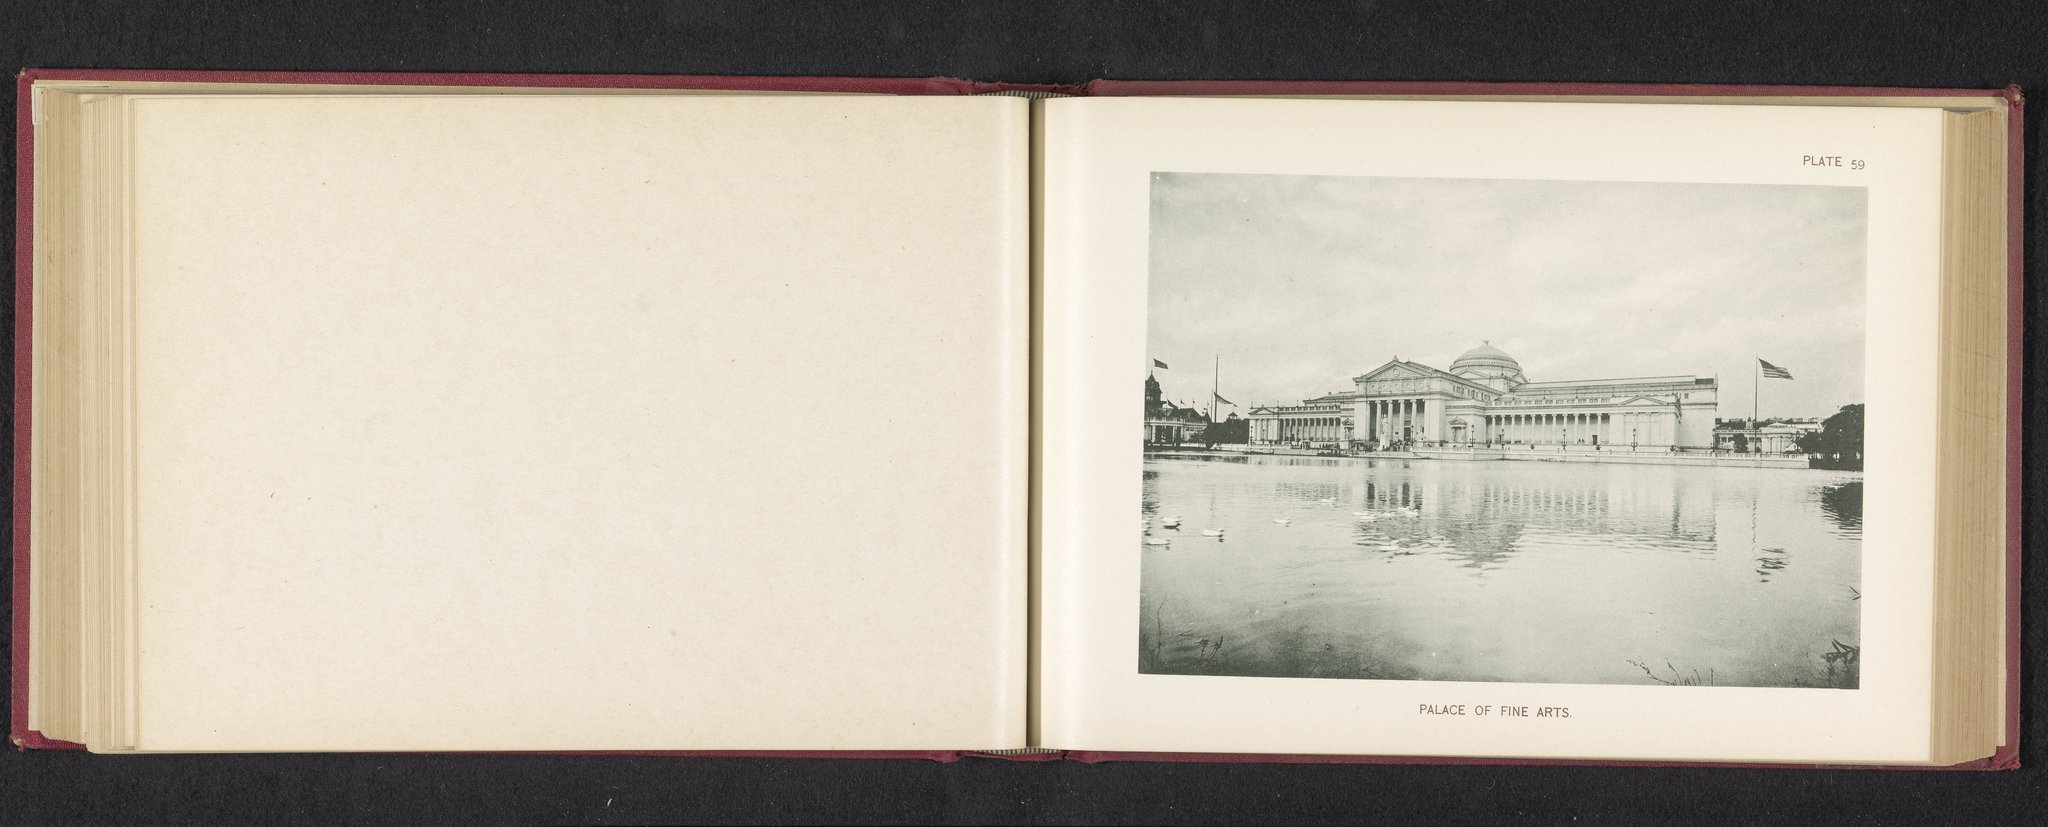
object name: page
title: Palace of Fine Arts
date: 1893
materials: paper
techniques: photograph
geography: chicago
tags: world fair, world exhibition, permanent exhibition, museum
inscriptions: number: ‘Plate 59’